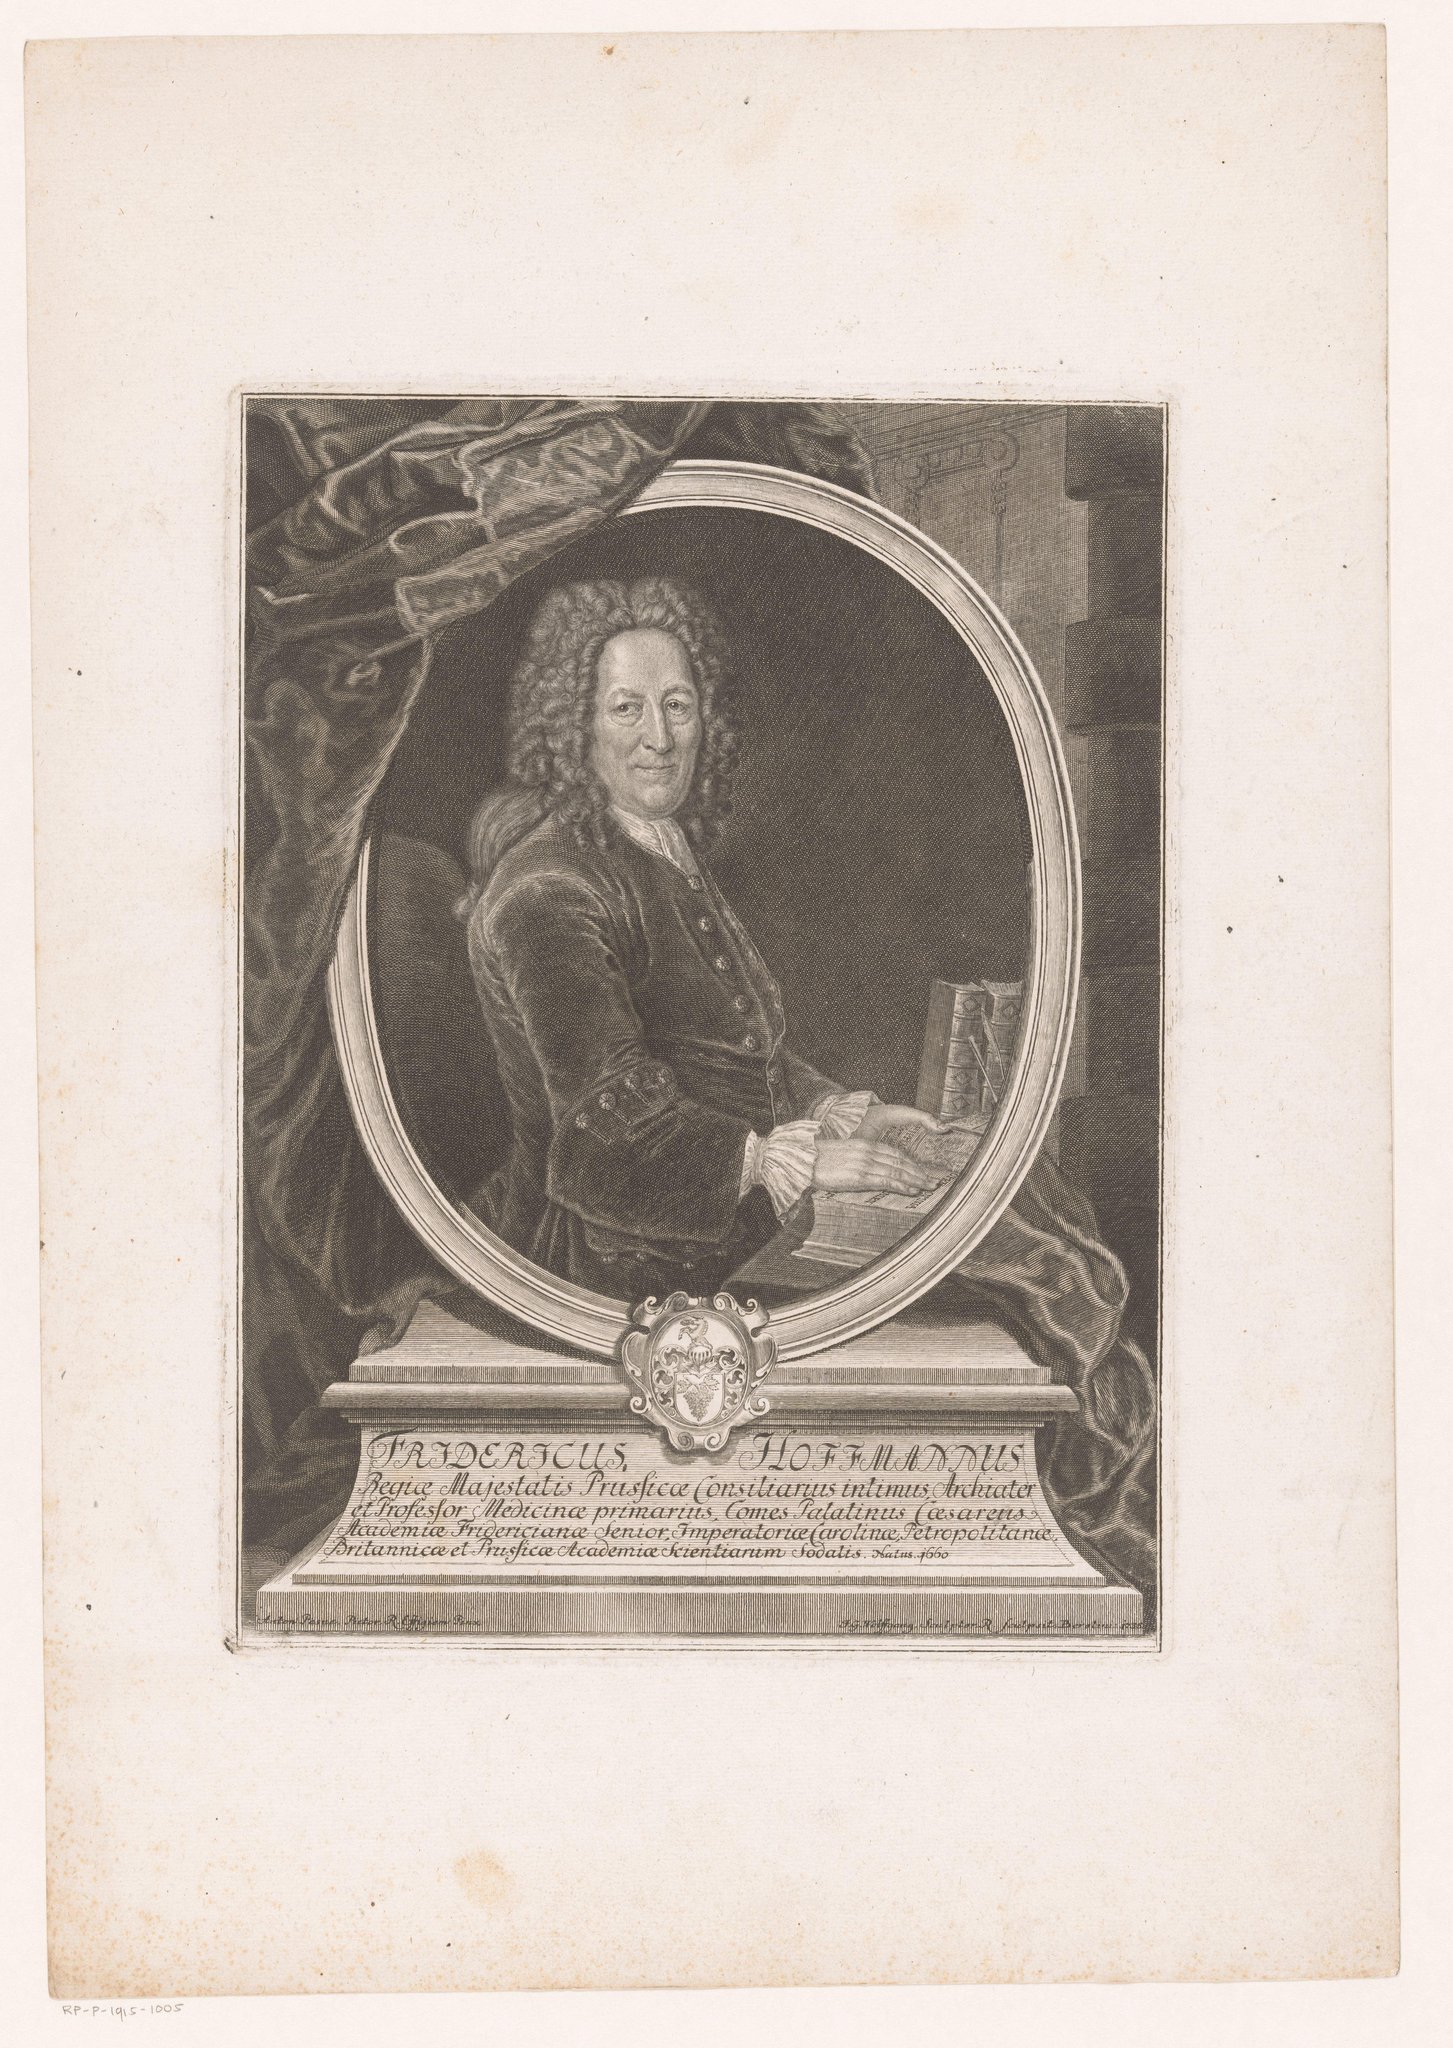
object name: print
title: Portret van Friedrich Hoffmann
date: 1735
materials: paper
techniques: engraving, etching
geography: berlin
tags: historical persons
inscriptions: collector's mark: Lugt 2228